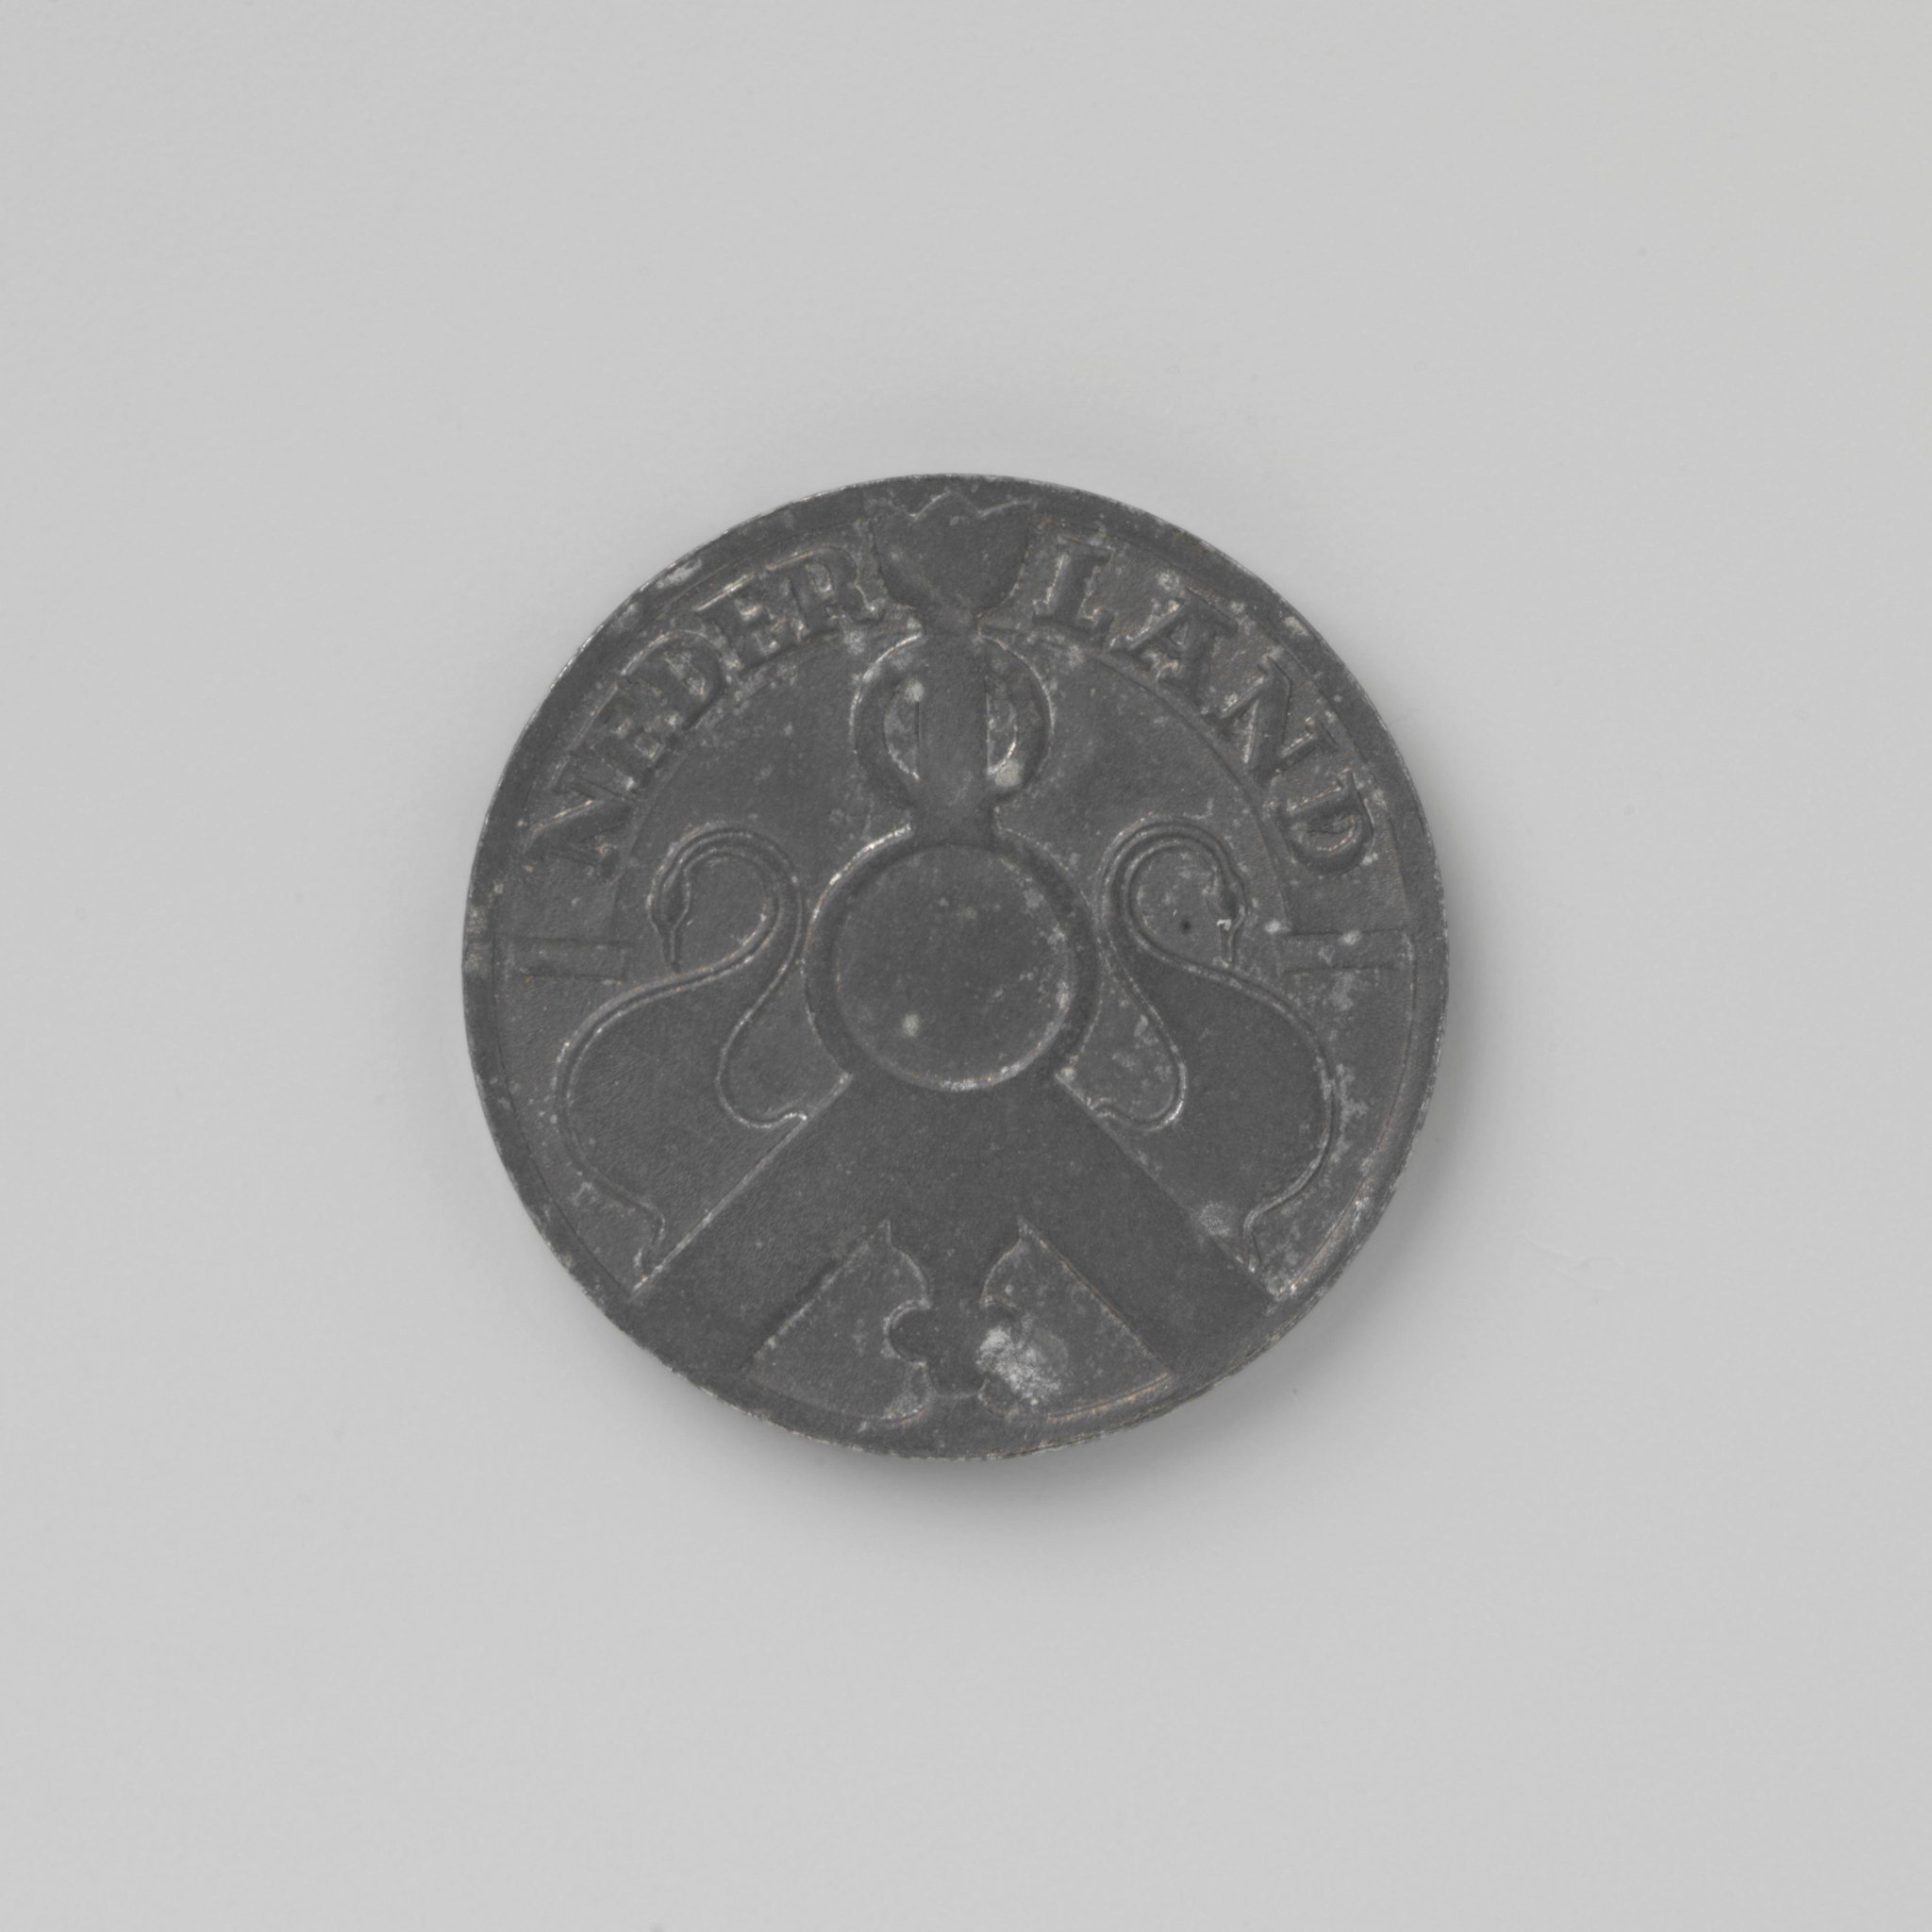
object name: coin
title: Nederland, 2½ cent,1941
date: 1941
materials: zinc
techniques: striking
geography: utrecht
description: Zinken munt. Voorzijde: Het Friese uleboerd. Keerzijde: waarde-aanduiding 2½ ct, rechts vier golven en een korenaar. daaronder op een band jaartal. Gladde rand.